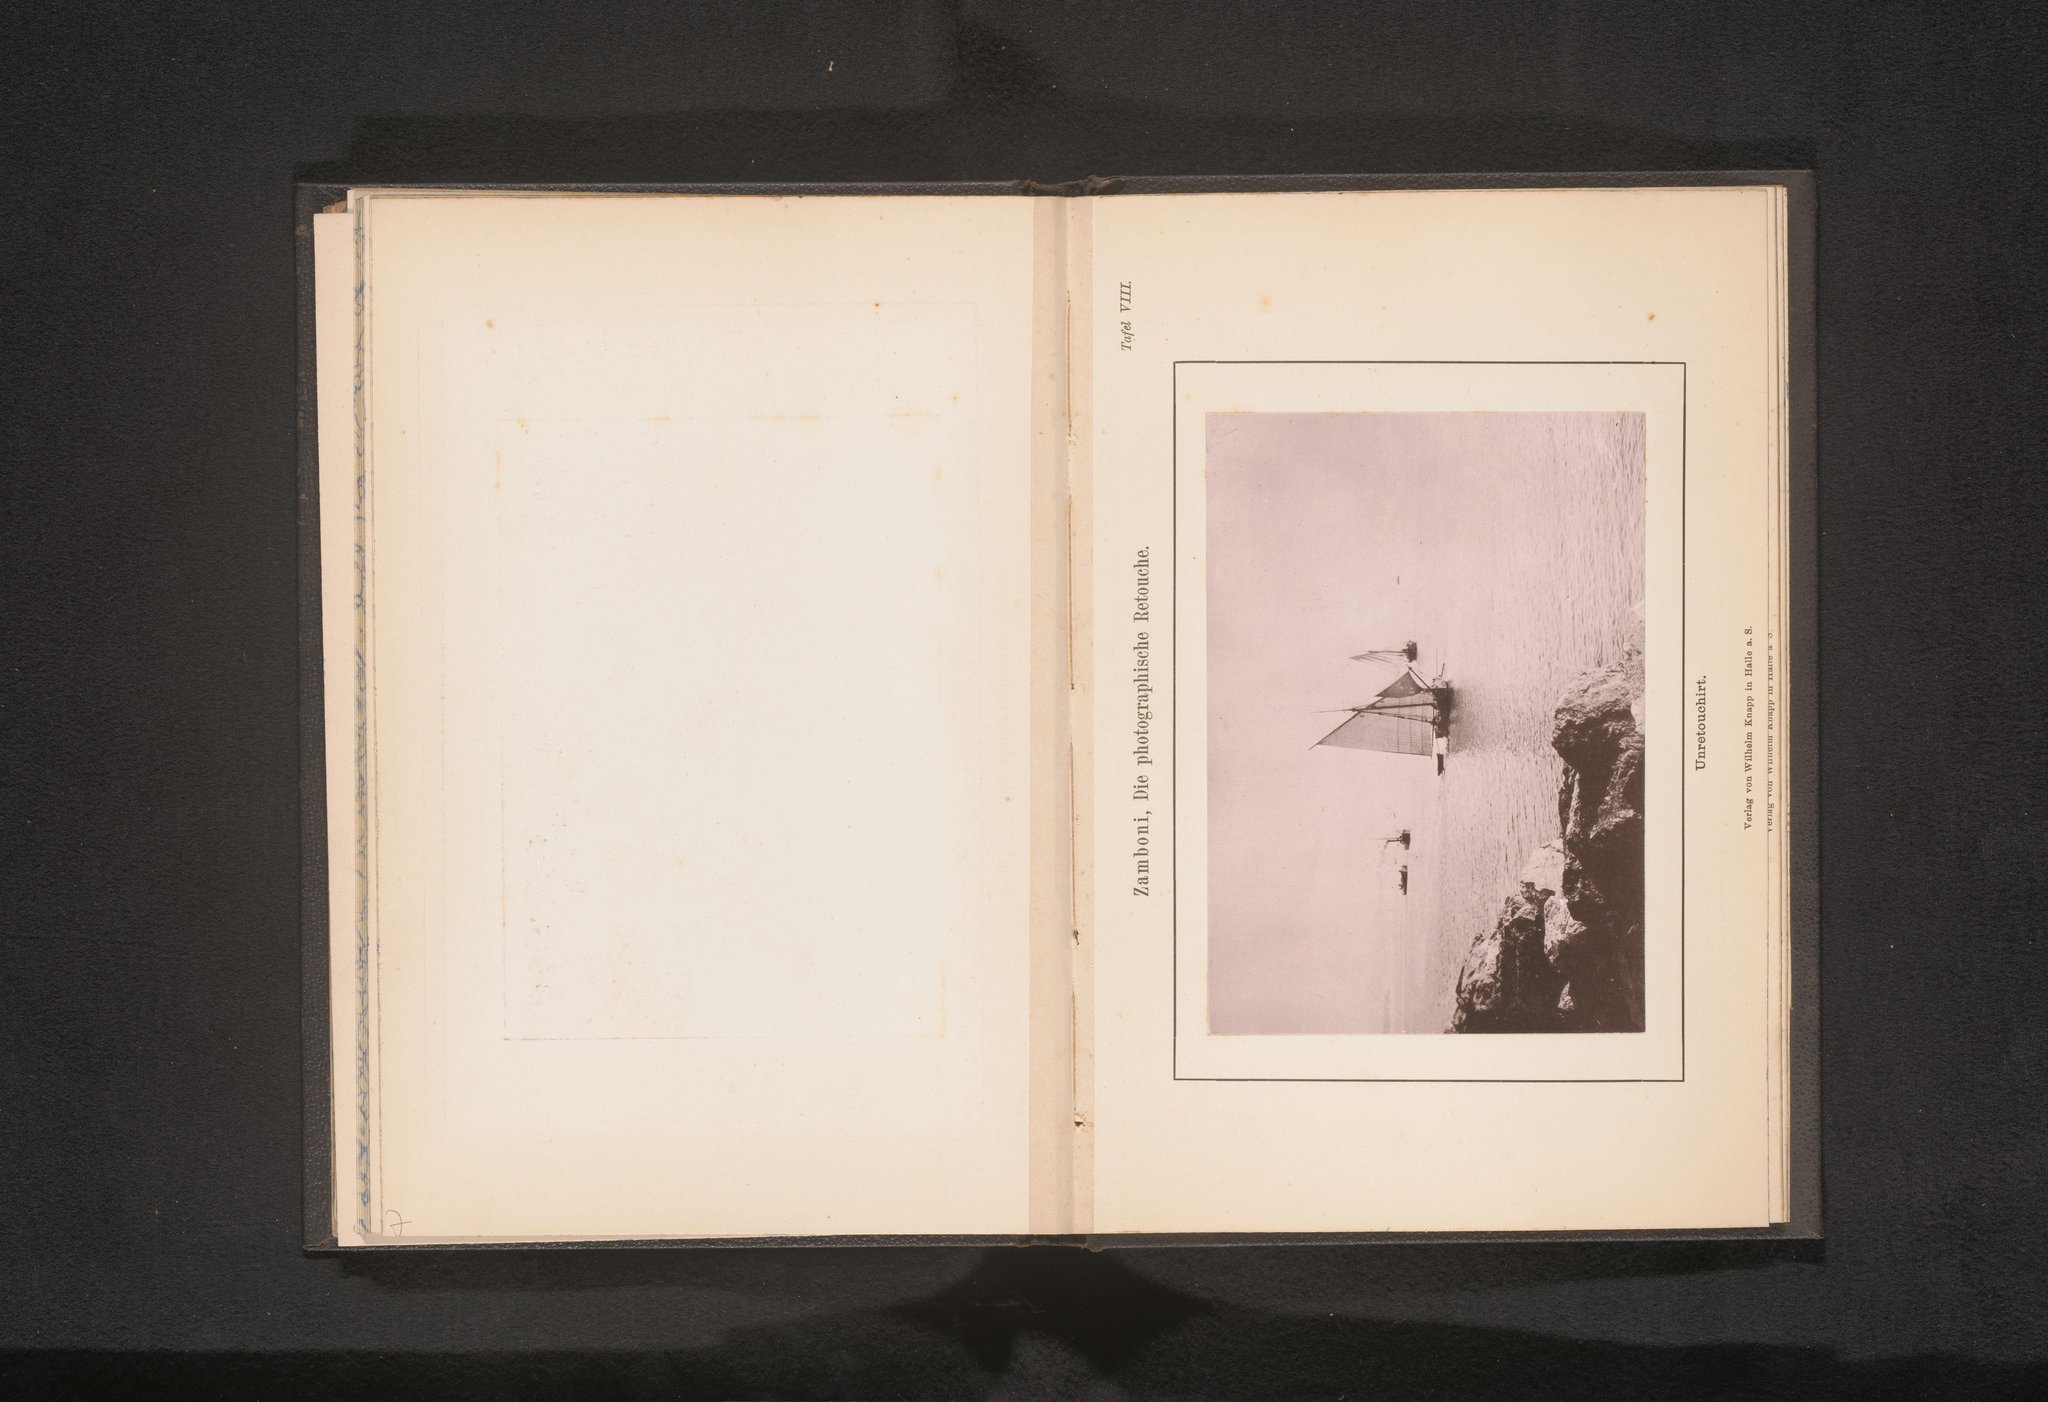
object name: photomechanical print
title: Gezicht op een boten langs een kust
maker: Anonymous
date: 1878-1888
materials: paper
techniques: photograph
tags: ships (in general), sea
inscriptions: number: ‘Tafel VIII.’, inscription: ‘Unretouchirt.’